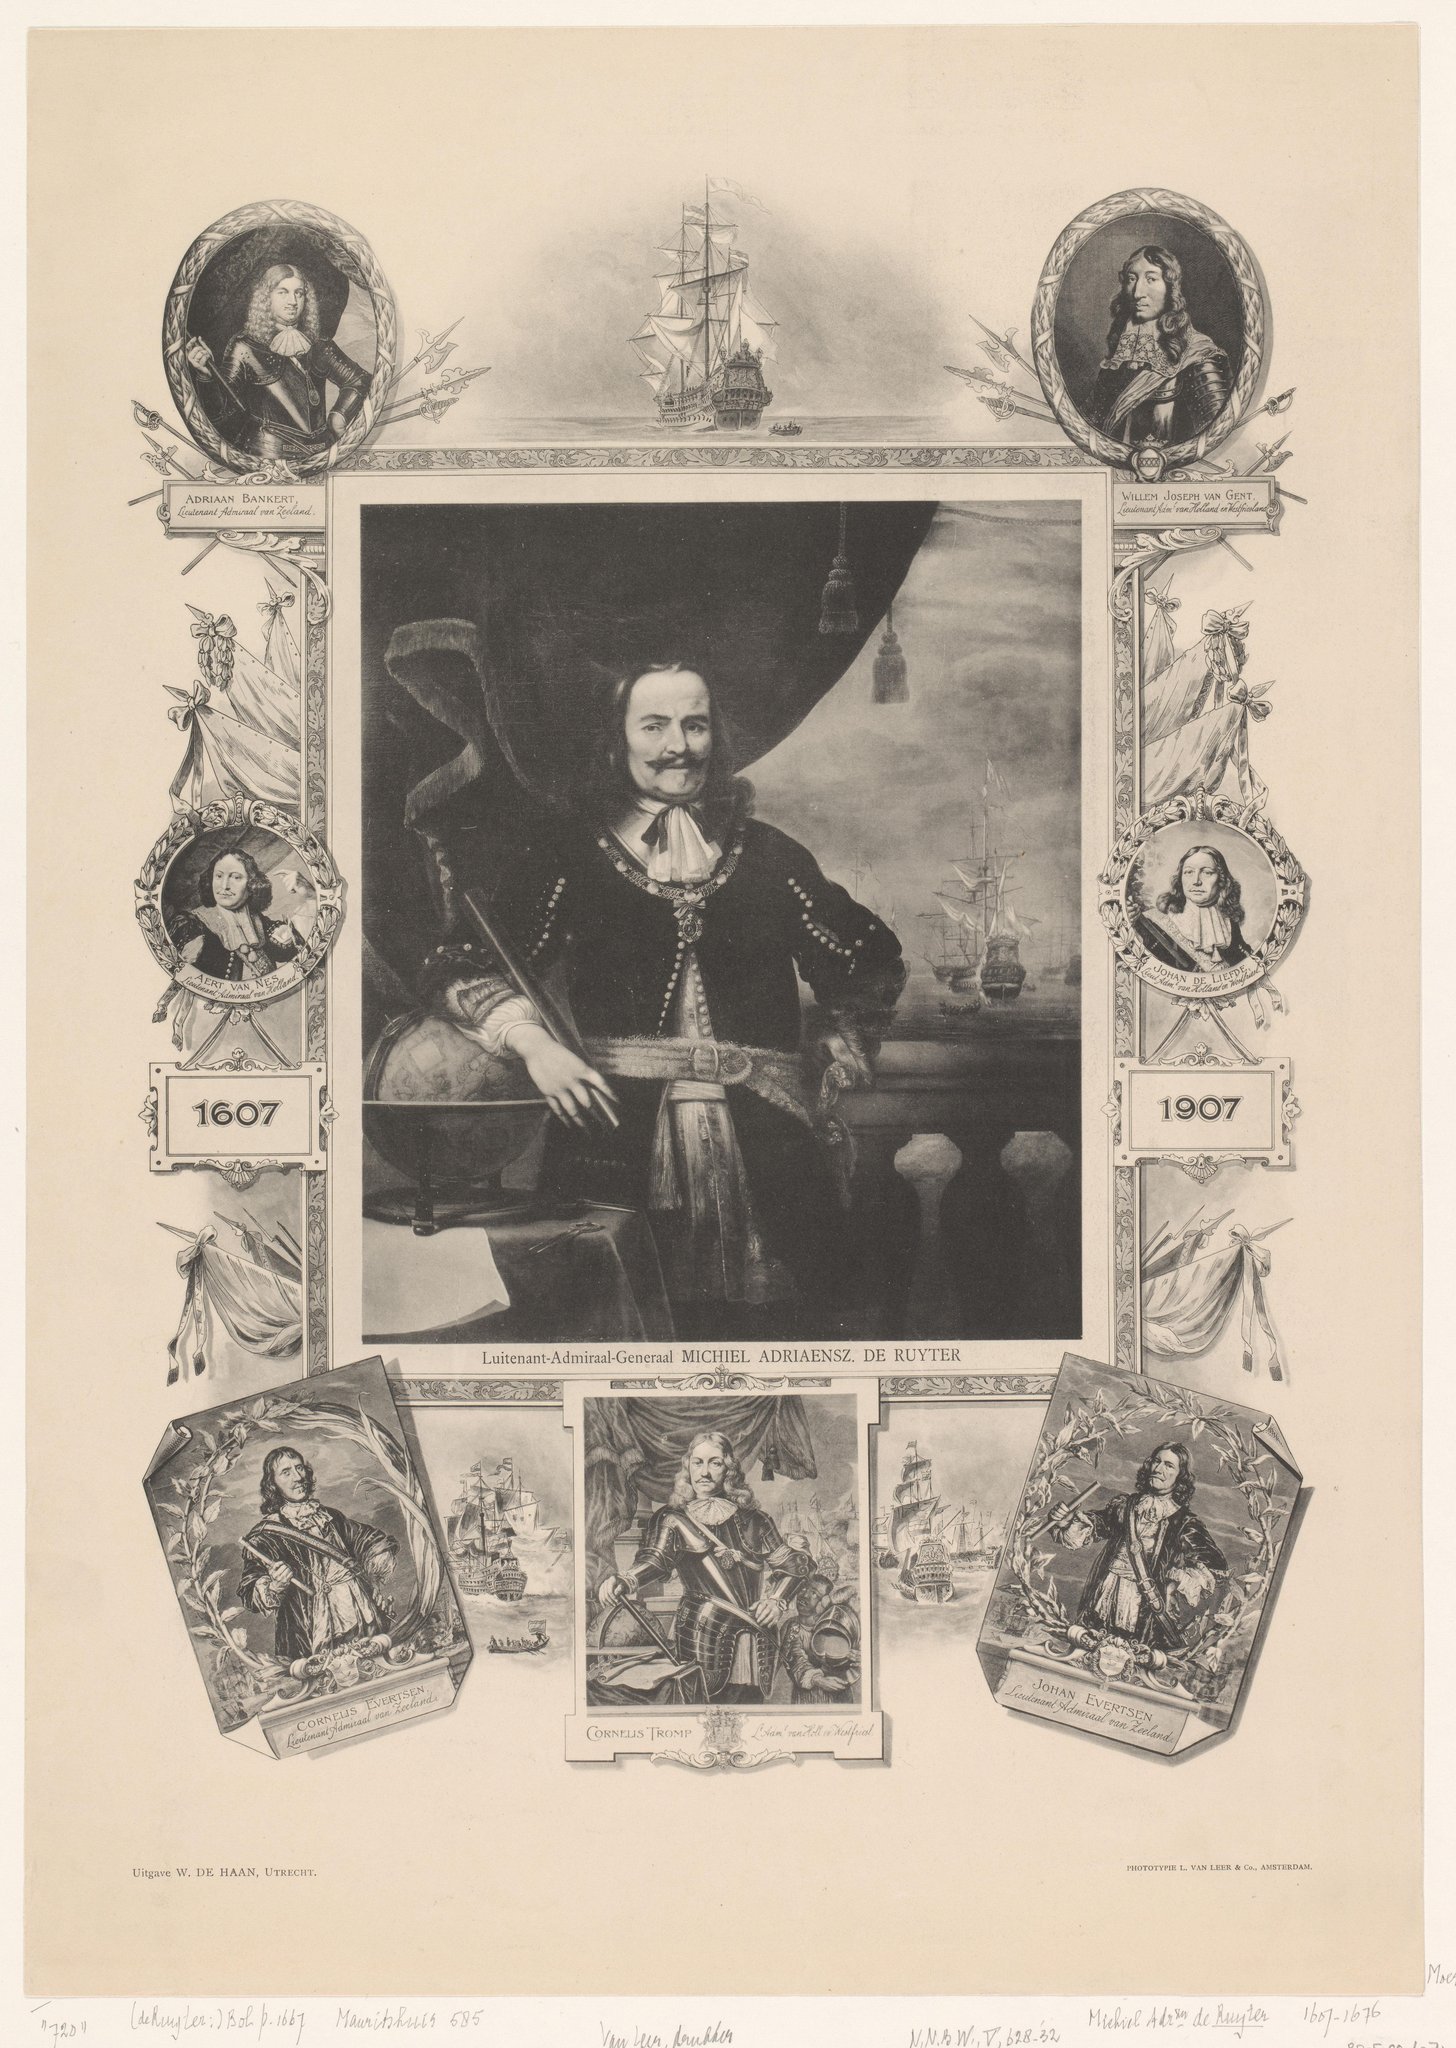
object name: photomechanical print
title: Reproducties van geschilderde portretten van Michiel de Ruyter (door Ferdinand Bol, 1667, SK-A-44) en (als randversiering) andere gezagvoerders ter zee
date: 1907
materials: paper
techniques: photograph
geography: utrecht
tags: commander-in-chief, admiral (+ naval force), painter at work, in his studio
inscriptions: collector's mark: Lugt 2228, annotation: ‘1606 / Luitenant-Admiraal-Generaal MICHIEL ADRIAENSZ. DE RUYTER / 1907 // Uitgave W. DE HAAN, UTRECHT. / PHOTOTYPIE L. VAN LEER & Co., AMSTERDAM.’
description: uitgegeven ter gelegenheid van de herdenking van de driehonderdste geboortedag van Michiel de Ruyter in 1907